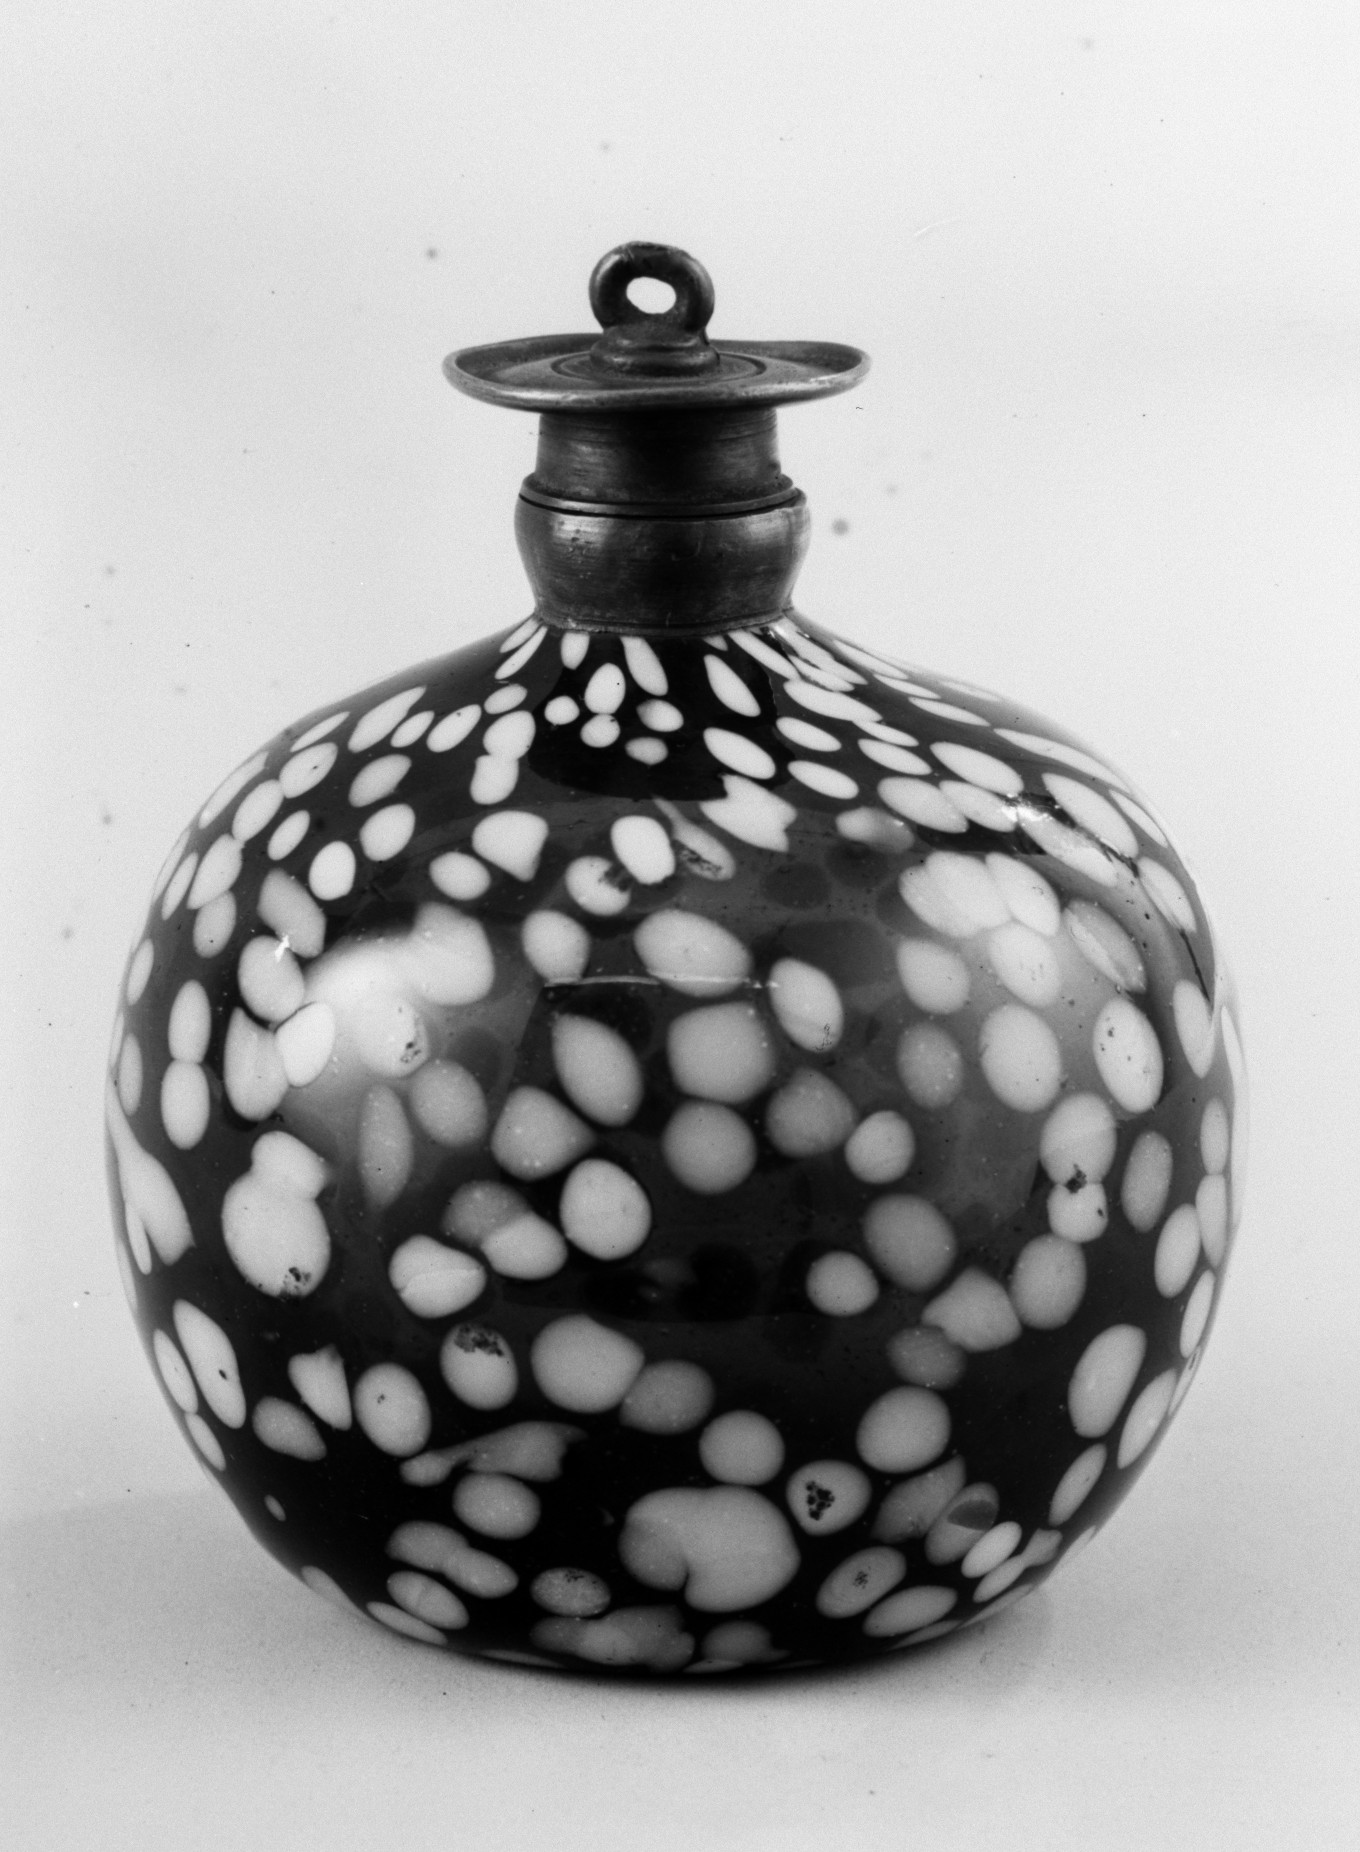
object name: bottle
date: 1701-1800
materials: glass, pewter